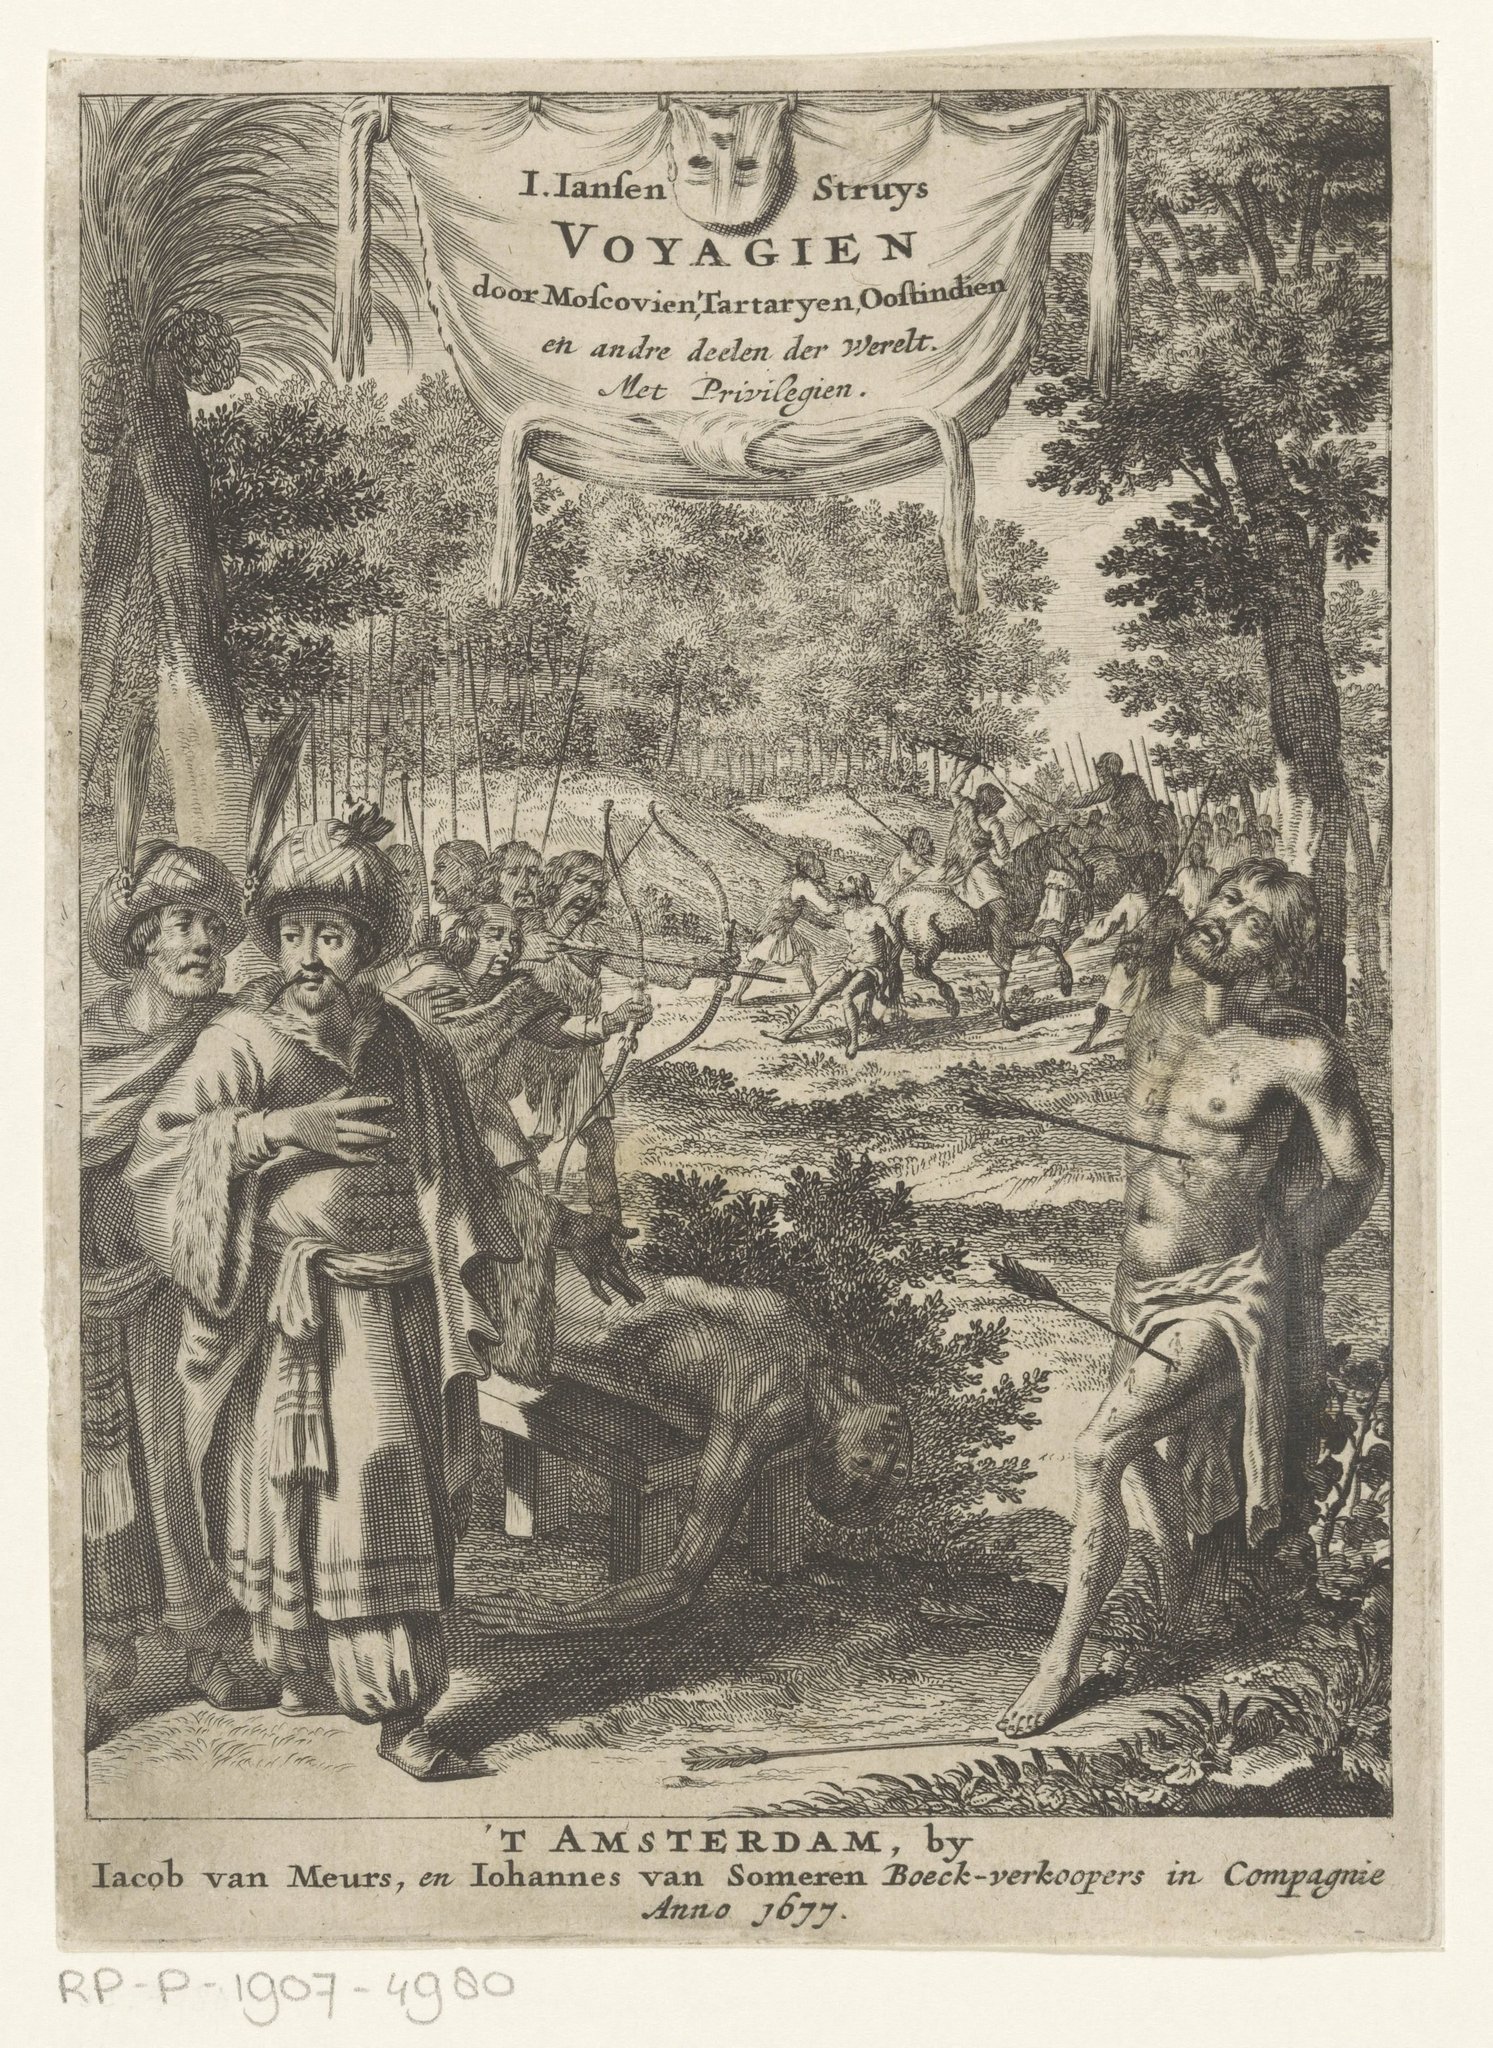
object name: titelblad, titelpagina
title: Voyagien door Moscovien, Tartaryen, Oostindien en andre deelen der Werelt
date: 1677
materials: paper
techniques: engraving, etching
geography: amsterdam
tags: violent death by arrow(s)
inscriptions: collector's mark: Lugt 2228, collector's mark: Lugt 2760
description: Titelpagina voor: Struys, J.J. Drie aanmerkelijke en seer rampspoedige reysen door Italien, Grieckenlandt, Lijslandt, Moscovien, Tartarijen, Meden, Persien, Oost-Indien, apen en verscheyden andere gewesten. Amsterdam: Meurs, Jacob van en Someren, Joannes van, 1677.